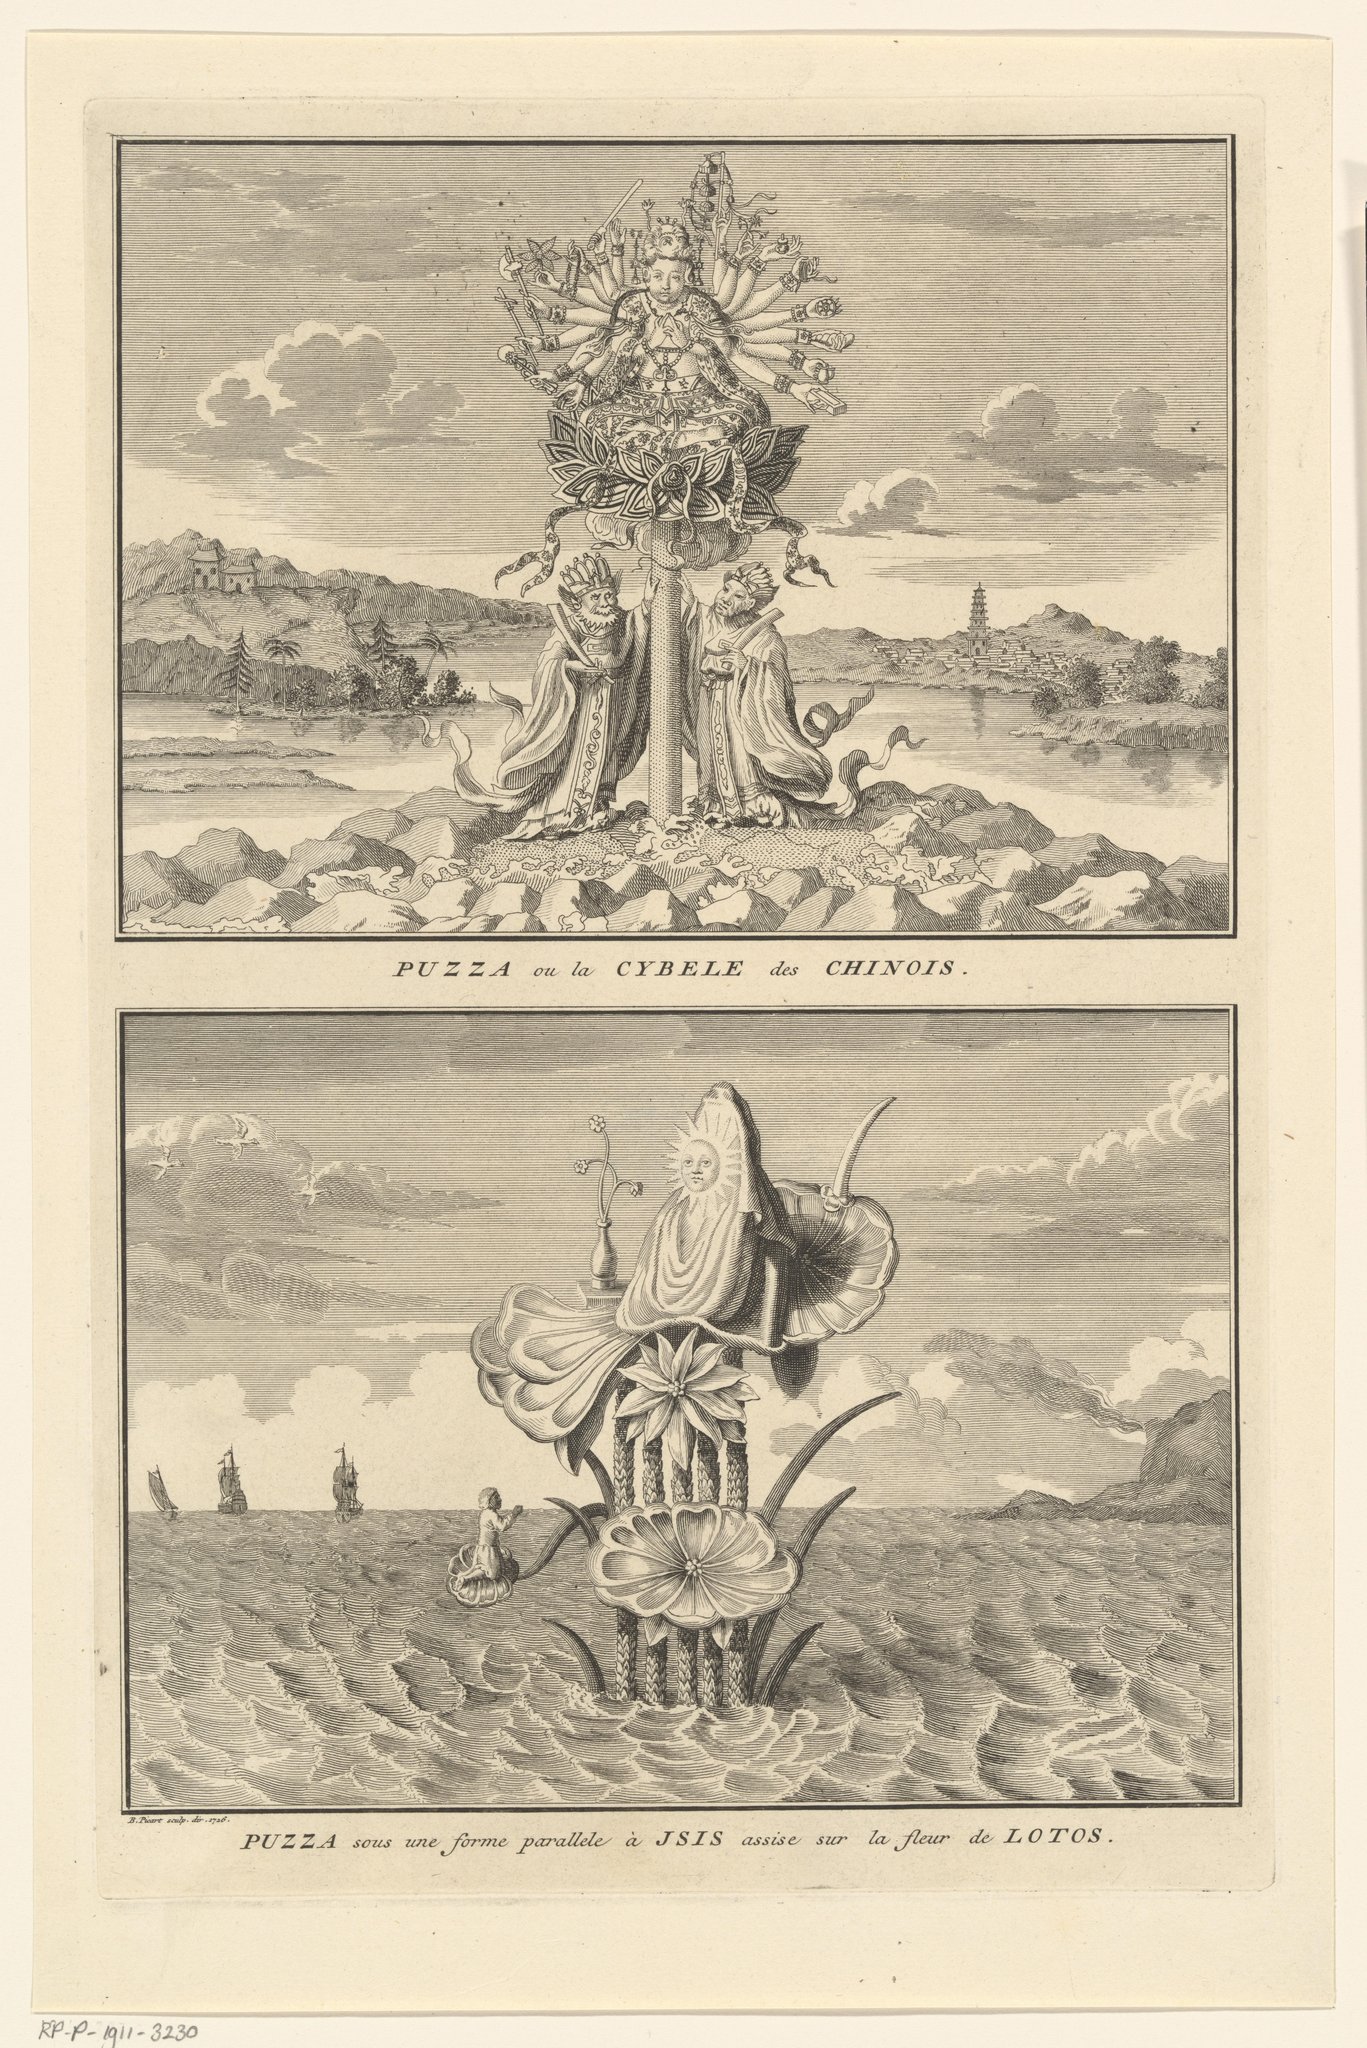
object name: print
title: The Chinese Goddess Pusa in Two Forms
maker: bernard picart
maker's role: draughtsman, print maker, publisher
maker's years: 1673-1733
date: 1726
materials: paper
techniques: engraving, etching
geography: amsterdam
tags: representations ~ gods, demi-gods, heroes, etc. (traditional chinese religions)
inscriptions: collector's mark: Lugt 2228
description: Standing in front of a pagoda and a rocky landscape is the Buddhist deity bodhisattva (Pusa). Picart portrayed her as the ancient Greek goddess Cybele. This was hardly new, for Jesuit writers had been disseminating this image since the early 17th century. This is but one example of Picart’s Eurocentric viewpoint, full of misconceptions about Chinese religion, which persisted despite the increasing trade exchange with China.